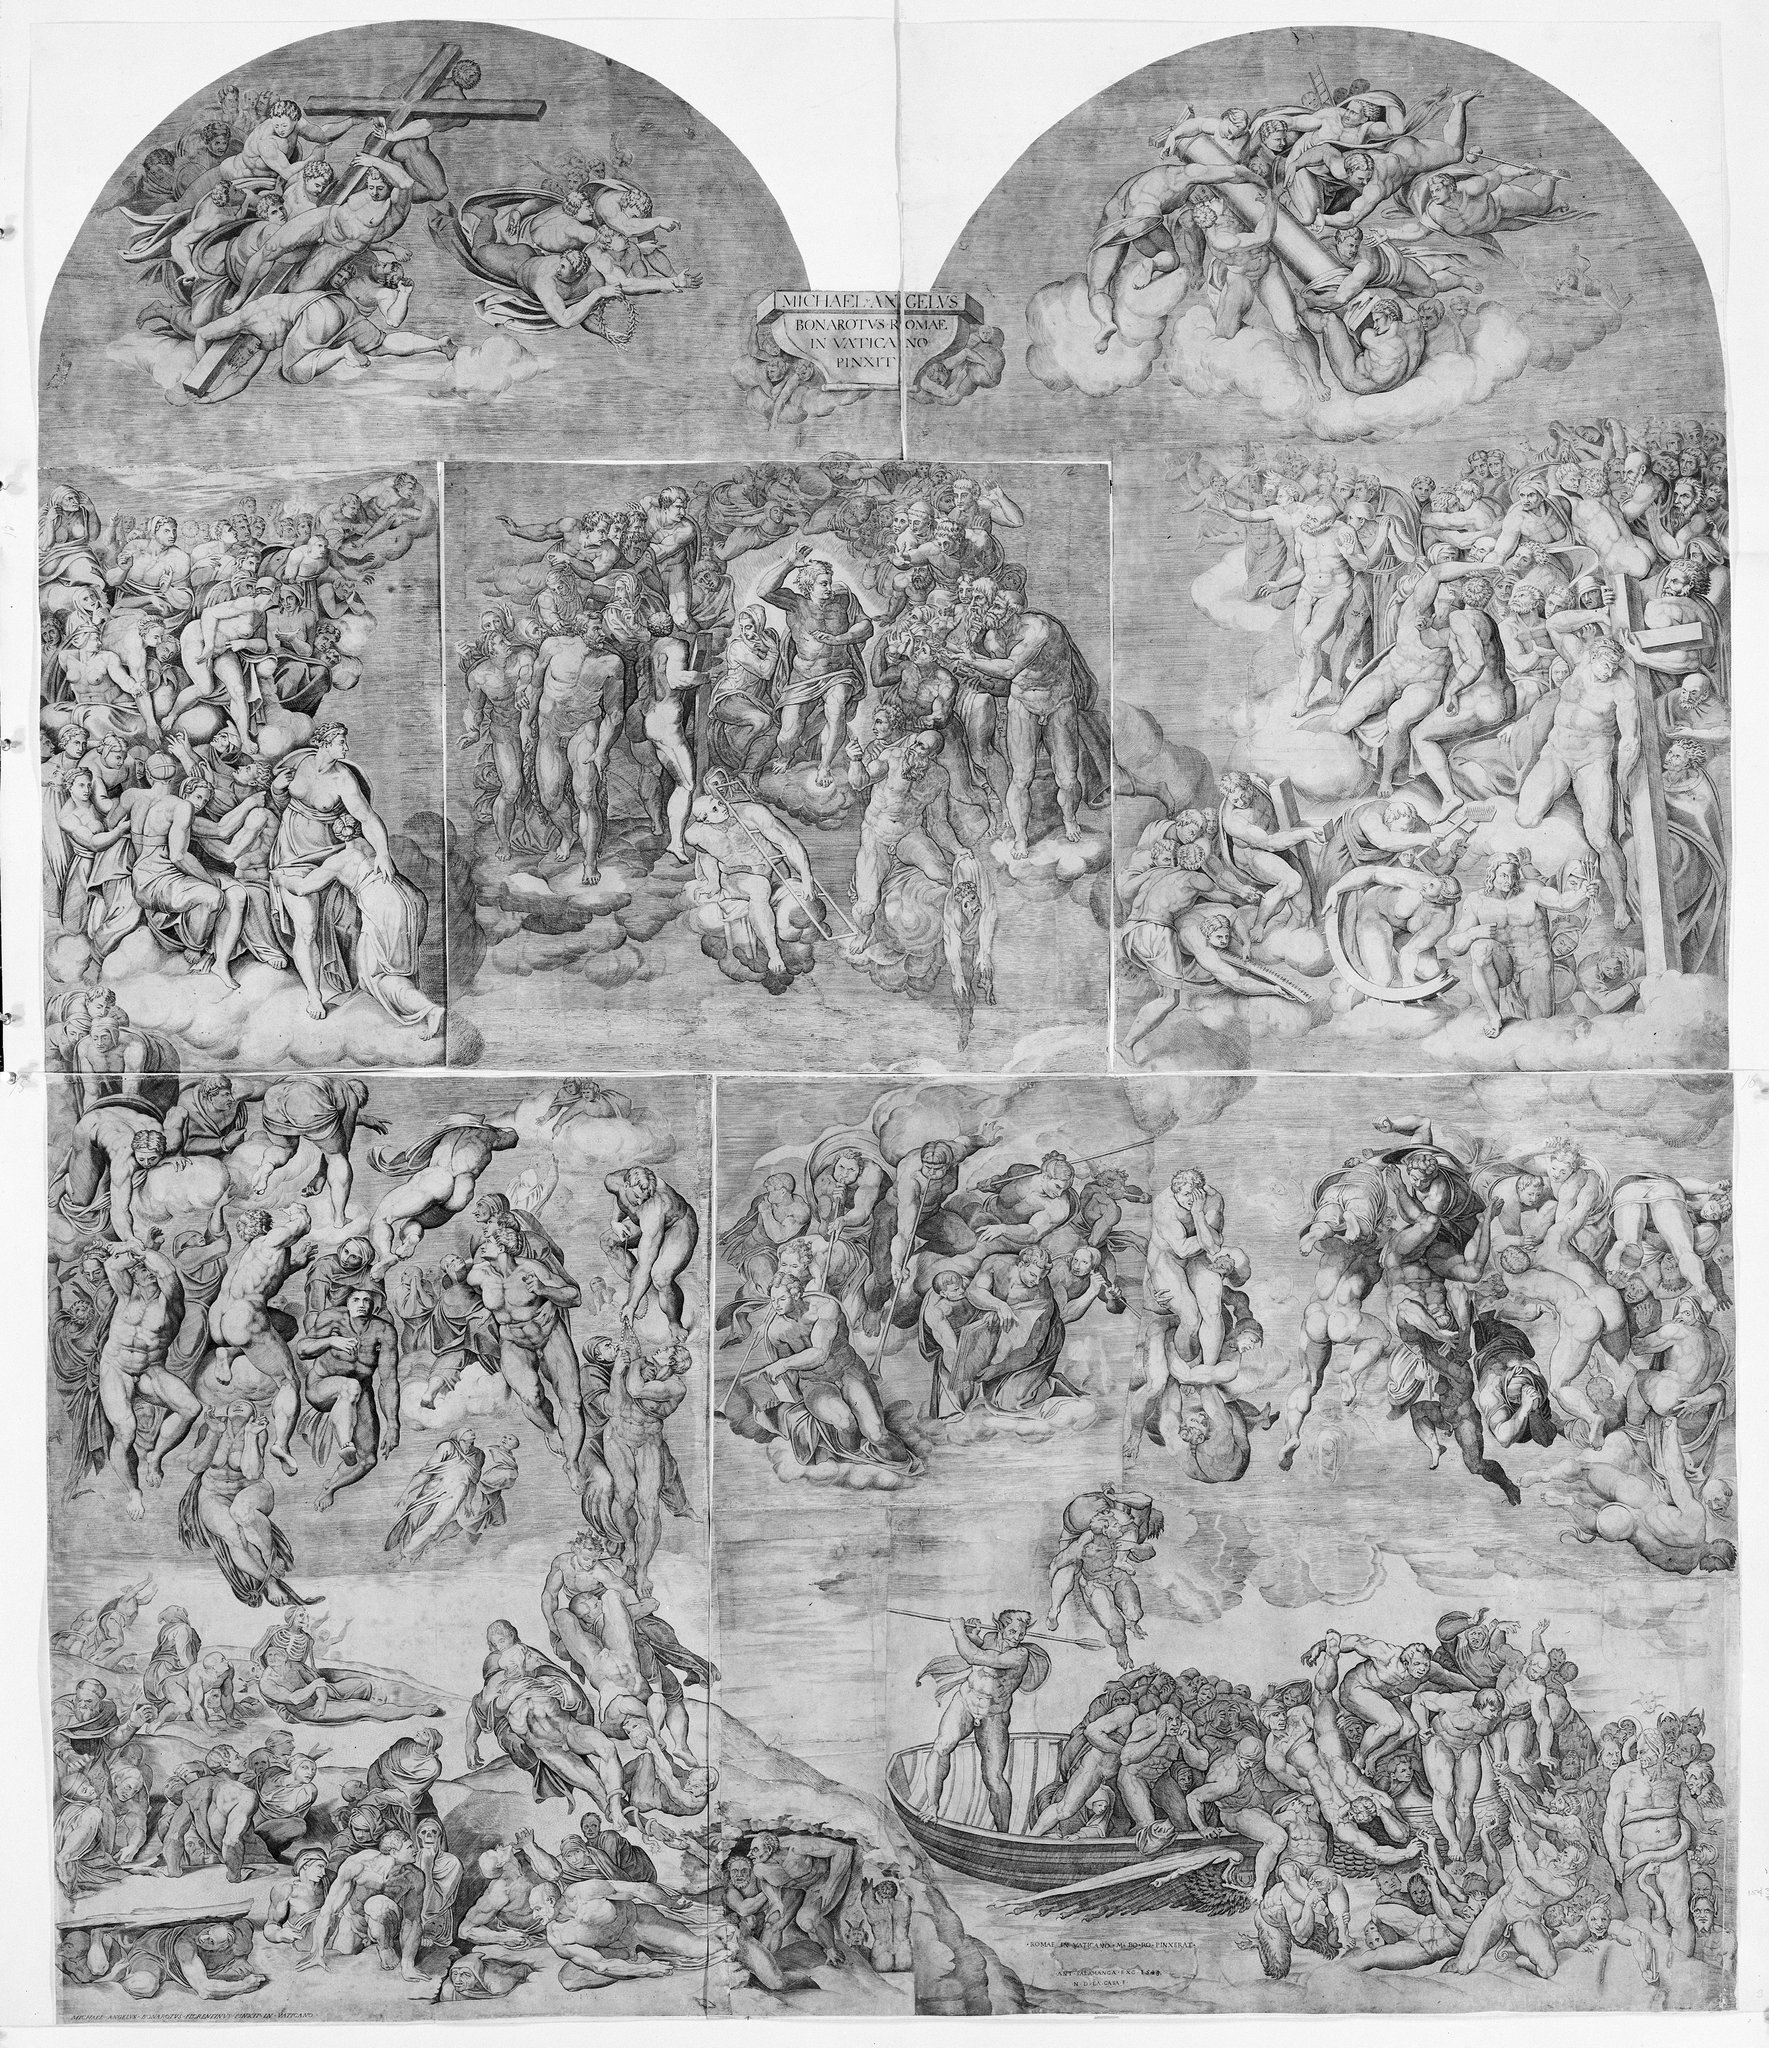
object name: print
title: Resurrection of the Dead (lower left section of the Last Judgment)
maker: niccolò della casa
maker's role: artist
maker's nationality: french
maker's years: 1543-1548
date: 1548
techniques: engraving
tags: male nudes,female nudes,cross,last judgement